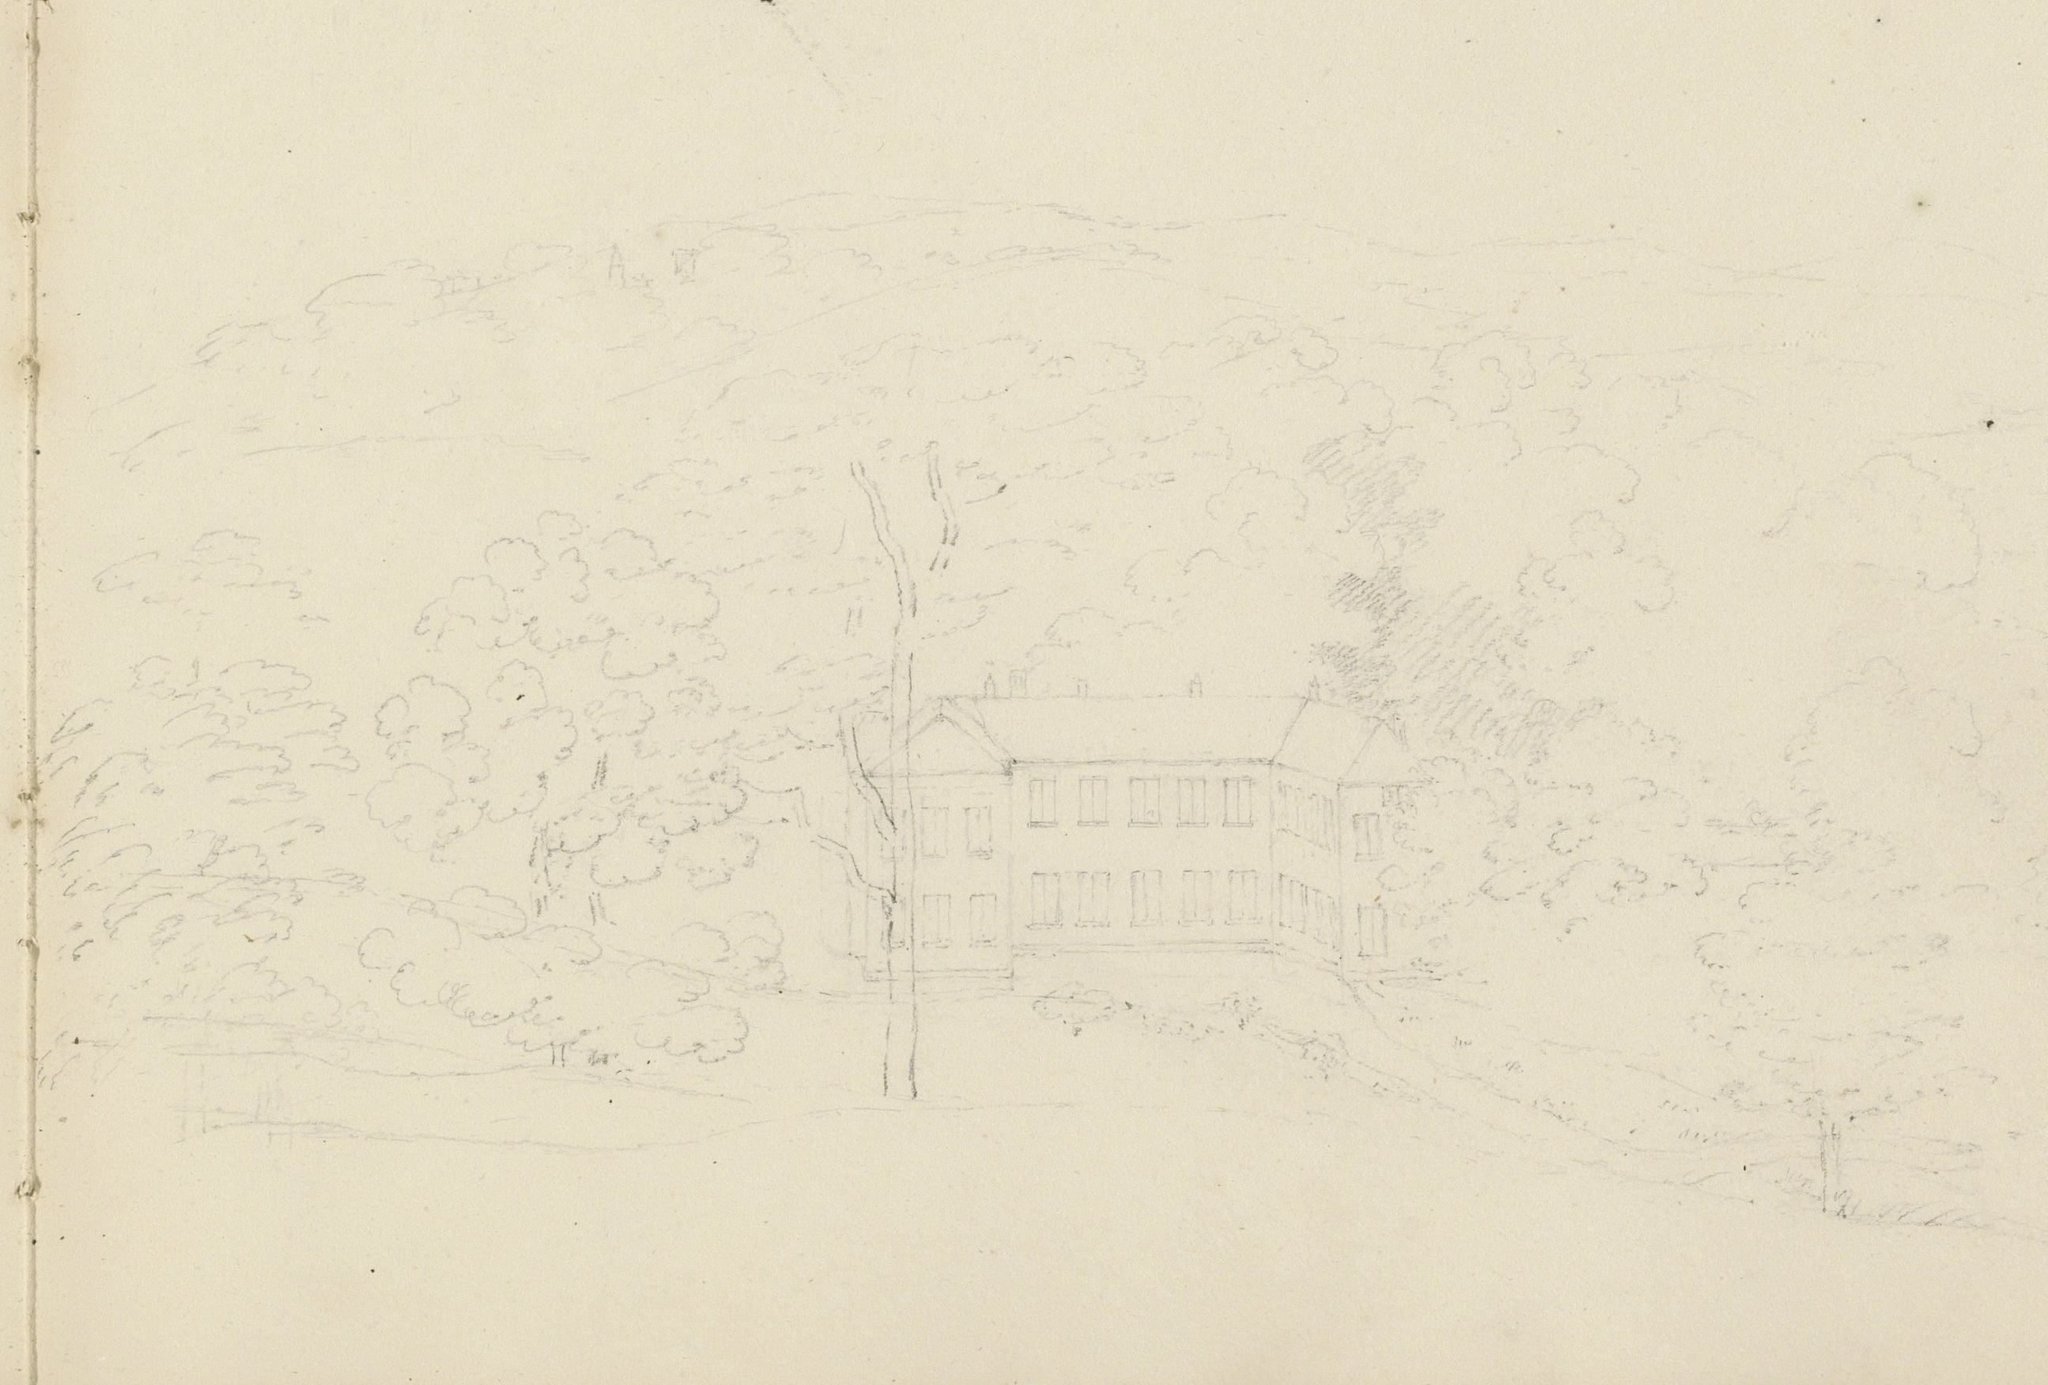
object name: sketchbook leaf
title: Heuvellandschap met een landhuis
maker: Anonymous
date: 1838-1865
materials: paper, pencil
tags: low hill country, country-house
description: Blad 13 recto uit een schetsboek met 45 bladen.